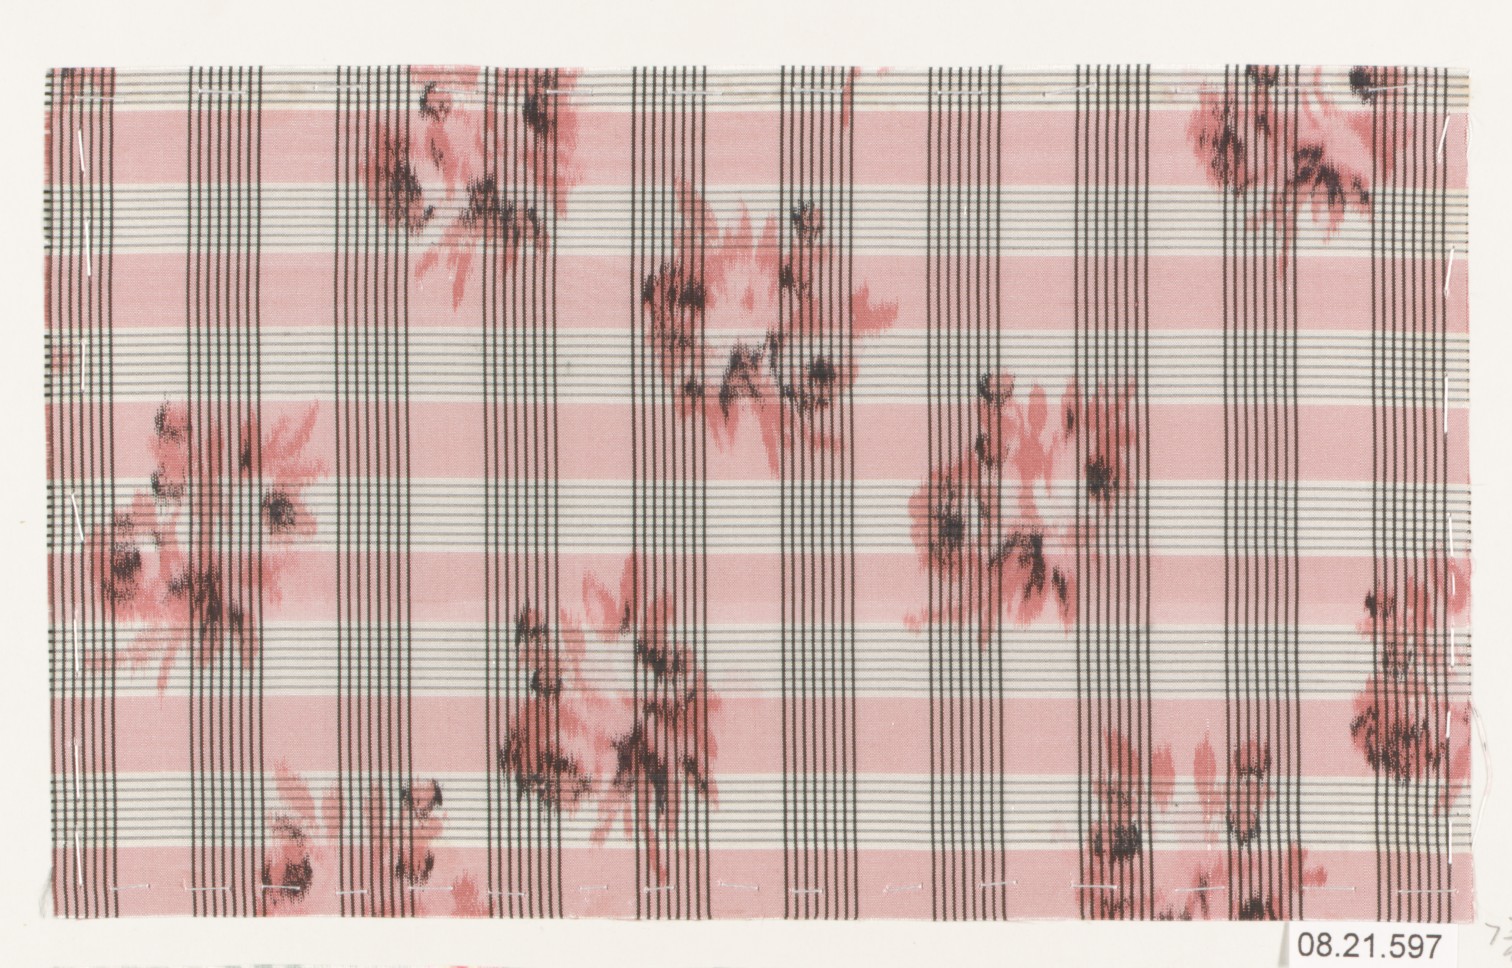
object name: textile sample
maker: Anonymous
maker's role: designer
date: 1900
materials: silk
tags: flowers